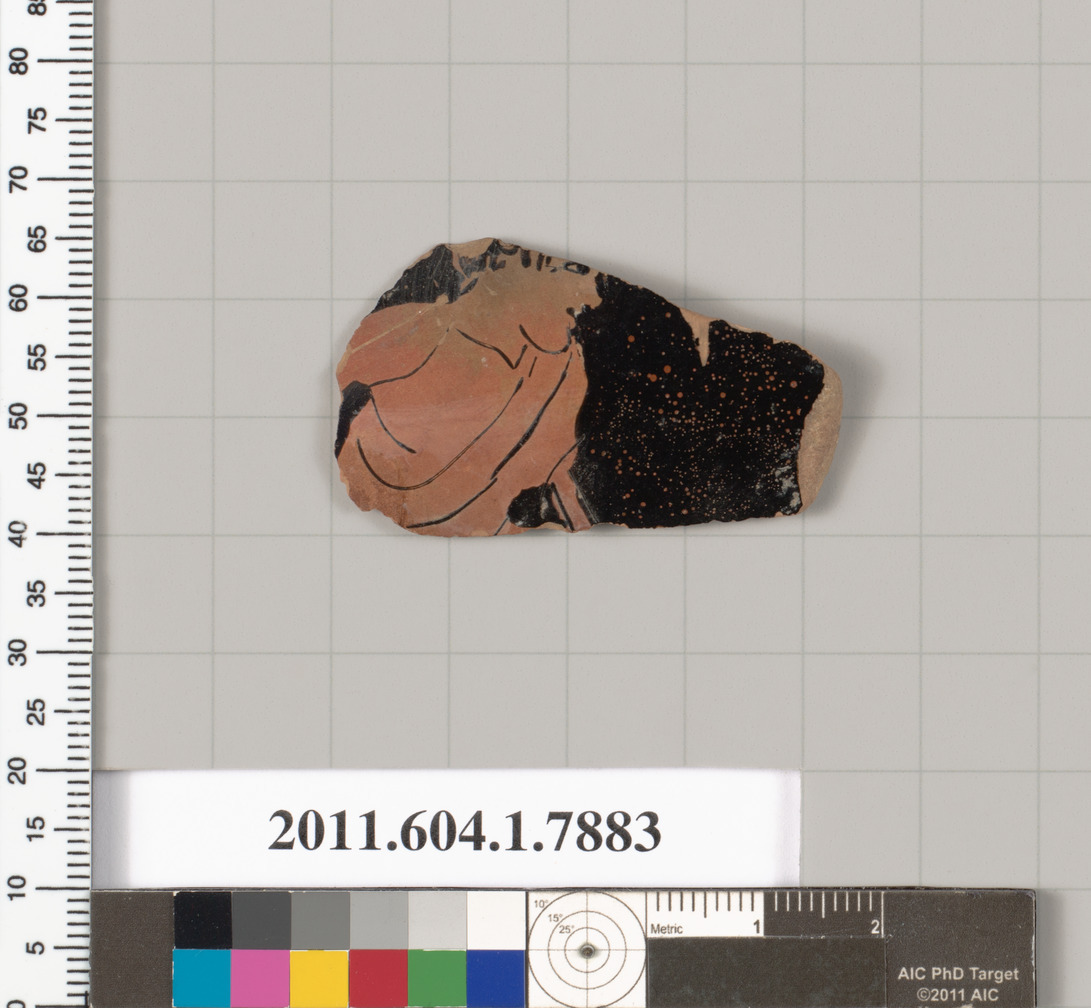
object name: kylix fragment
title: Terracotta fragment of a kylix (drinking cup)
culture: greek, attic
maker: veii painter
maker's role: artist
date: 460-450 BCE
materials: terracotta